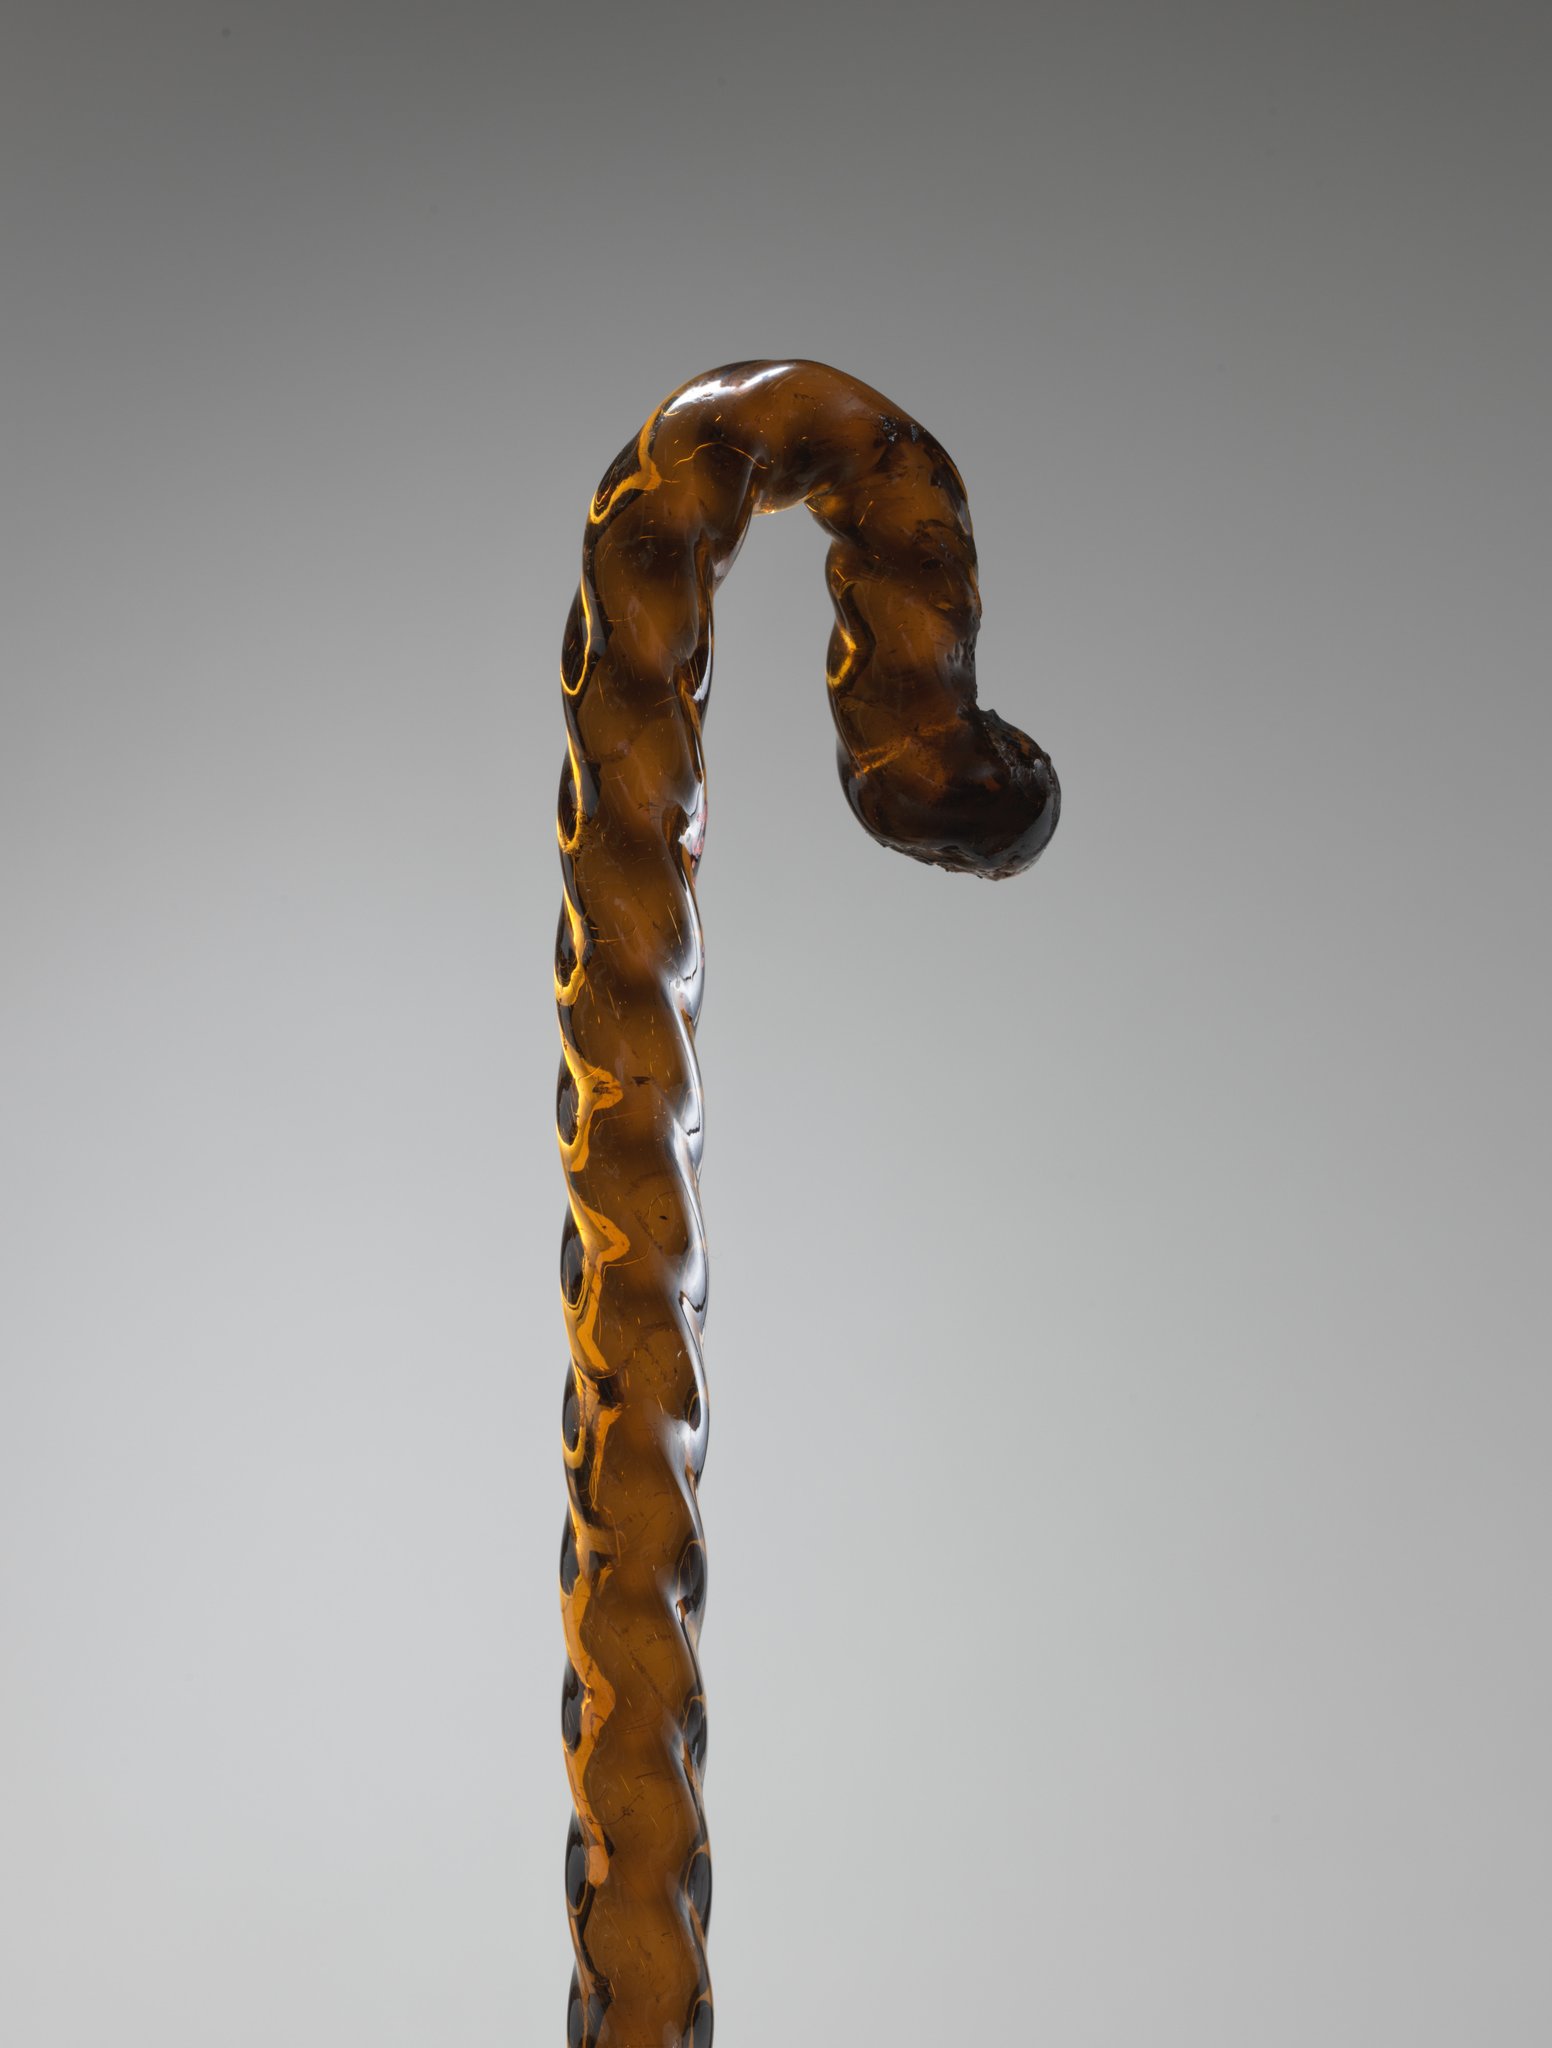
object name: cane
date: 1701-1800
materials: glass